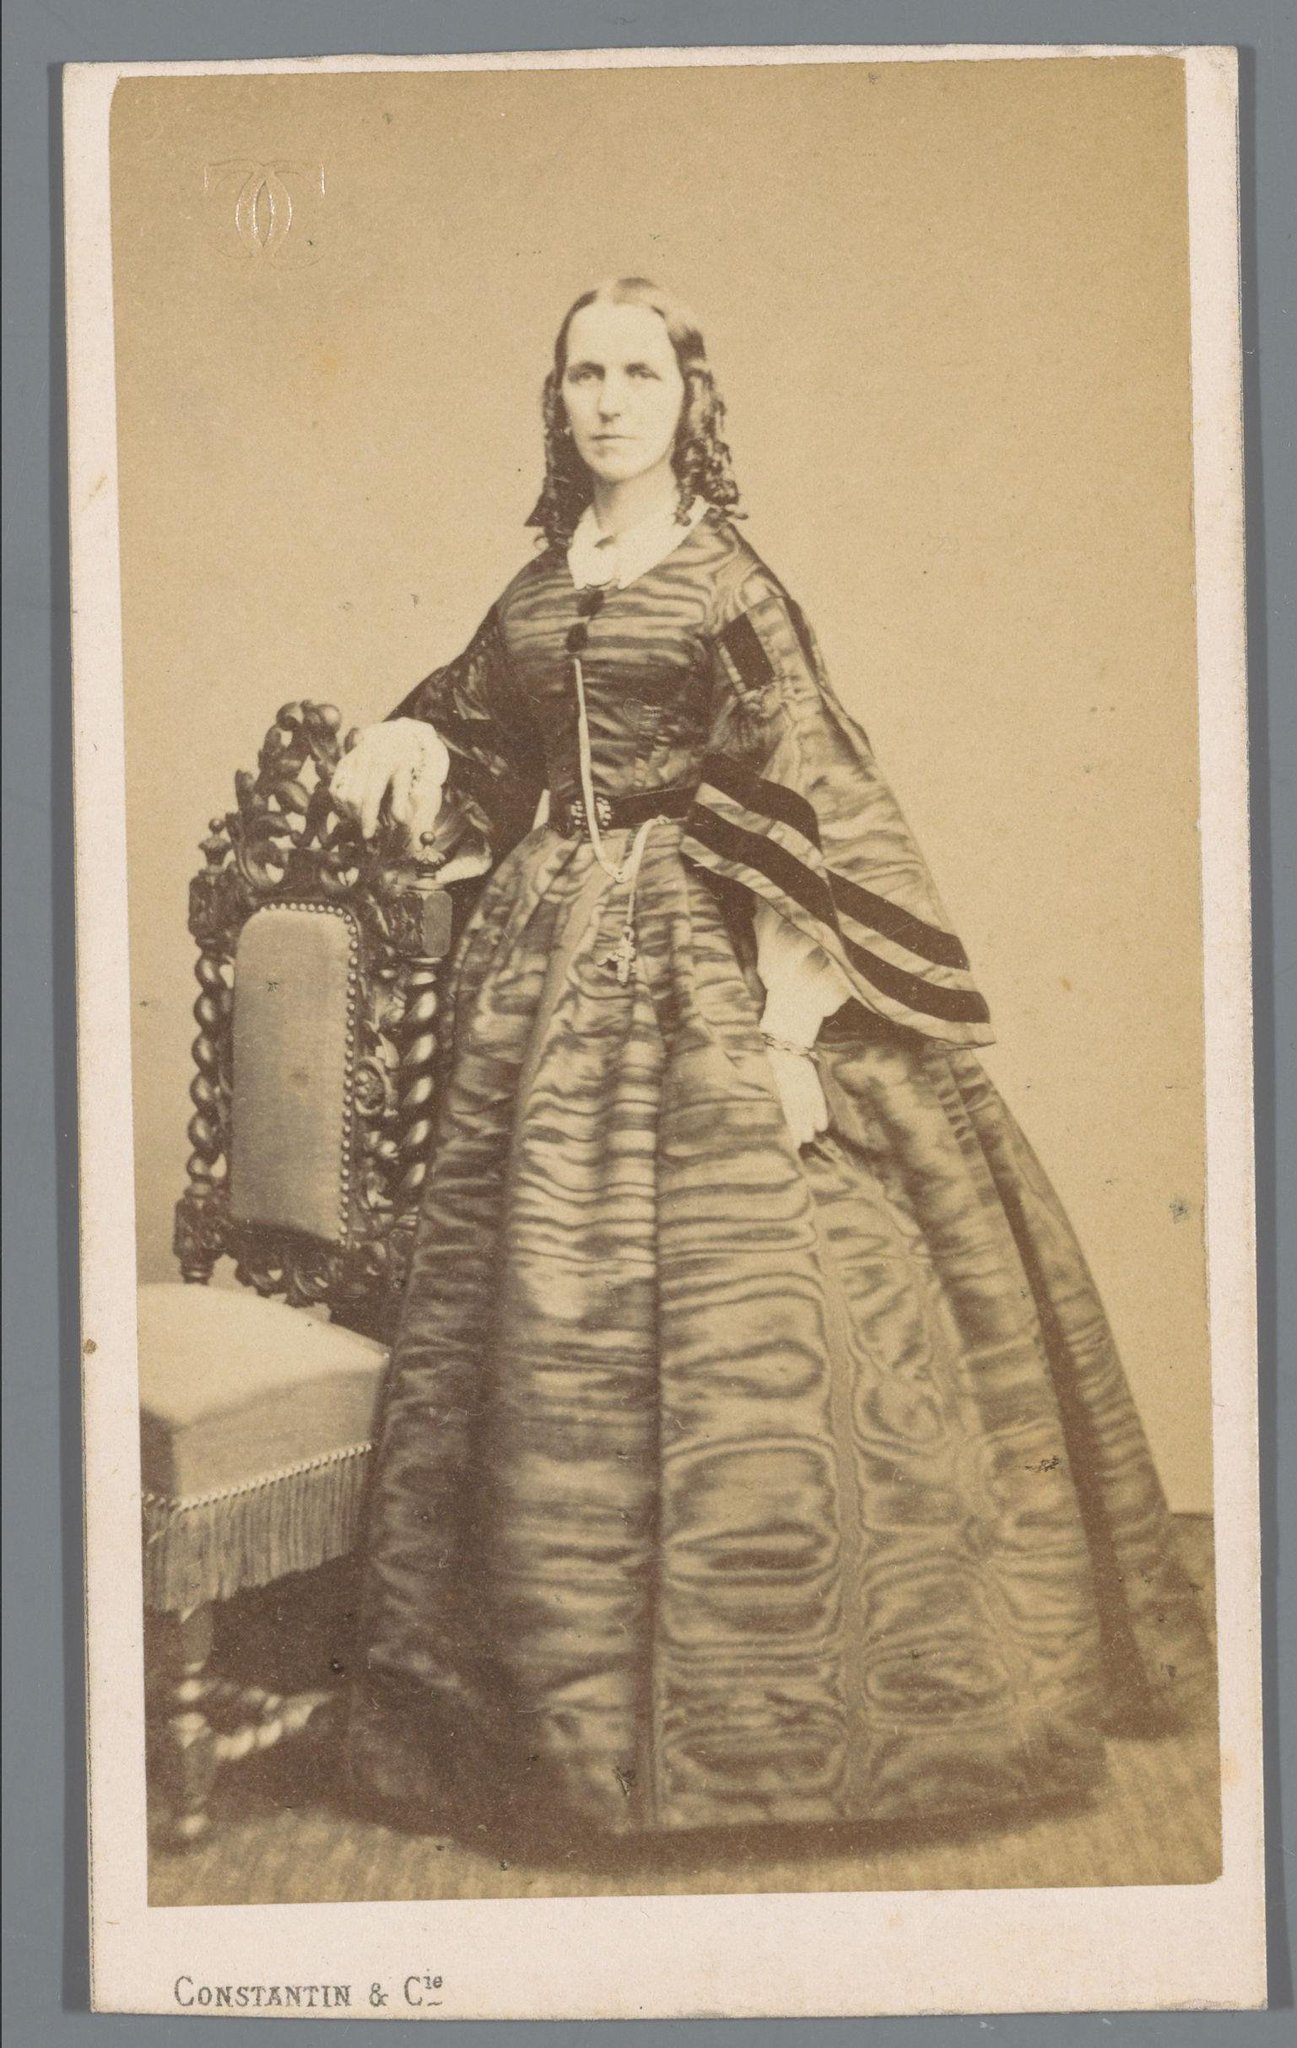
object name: photograph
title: Portret van een onbekende vrouw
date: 1855-1885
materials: cardboard, paper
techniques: albumen print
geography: paris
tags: adult woman, anonymous historical person portrayed, paris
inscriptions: inscription: ‘Constantin & Cie.’, monogram: ‘CC’, inscription: ‘Constantin & Cie./ Rue Chauchat, 11./ et/ Rue de Provence, 26./ Paris.’